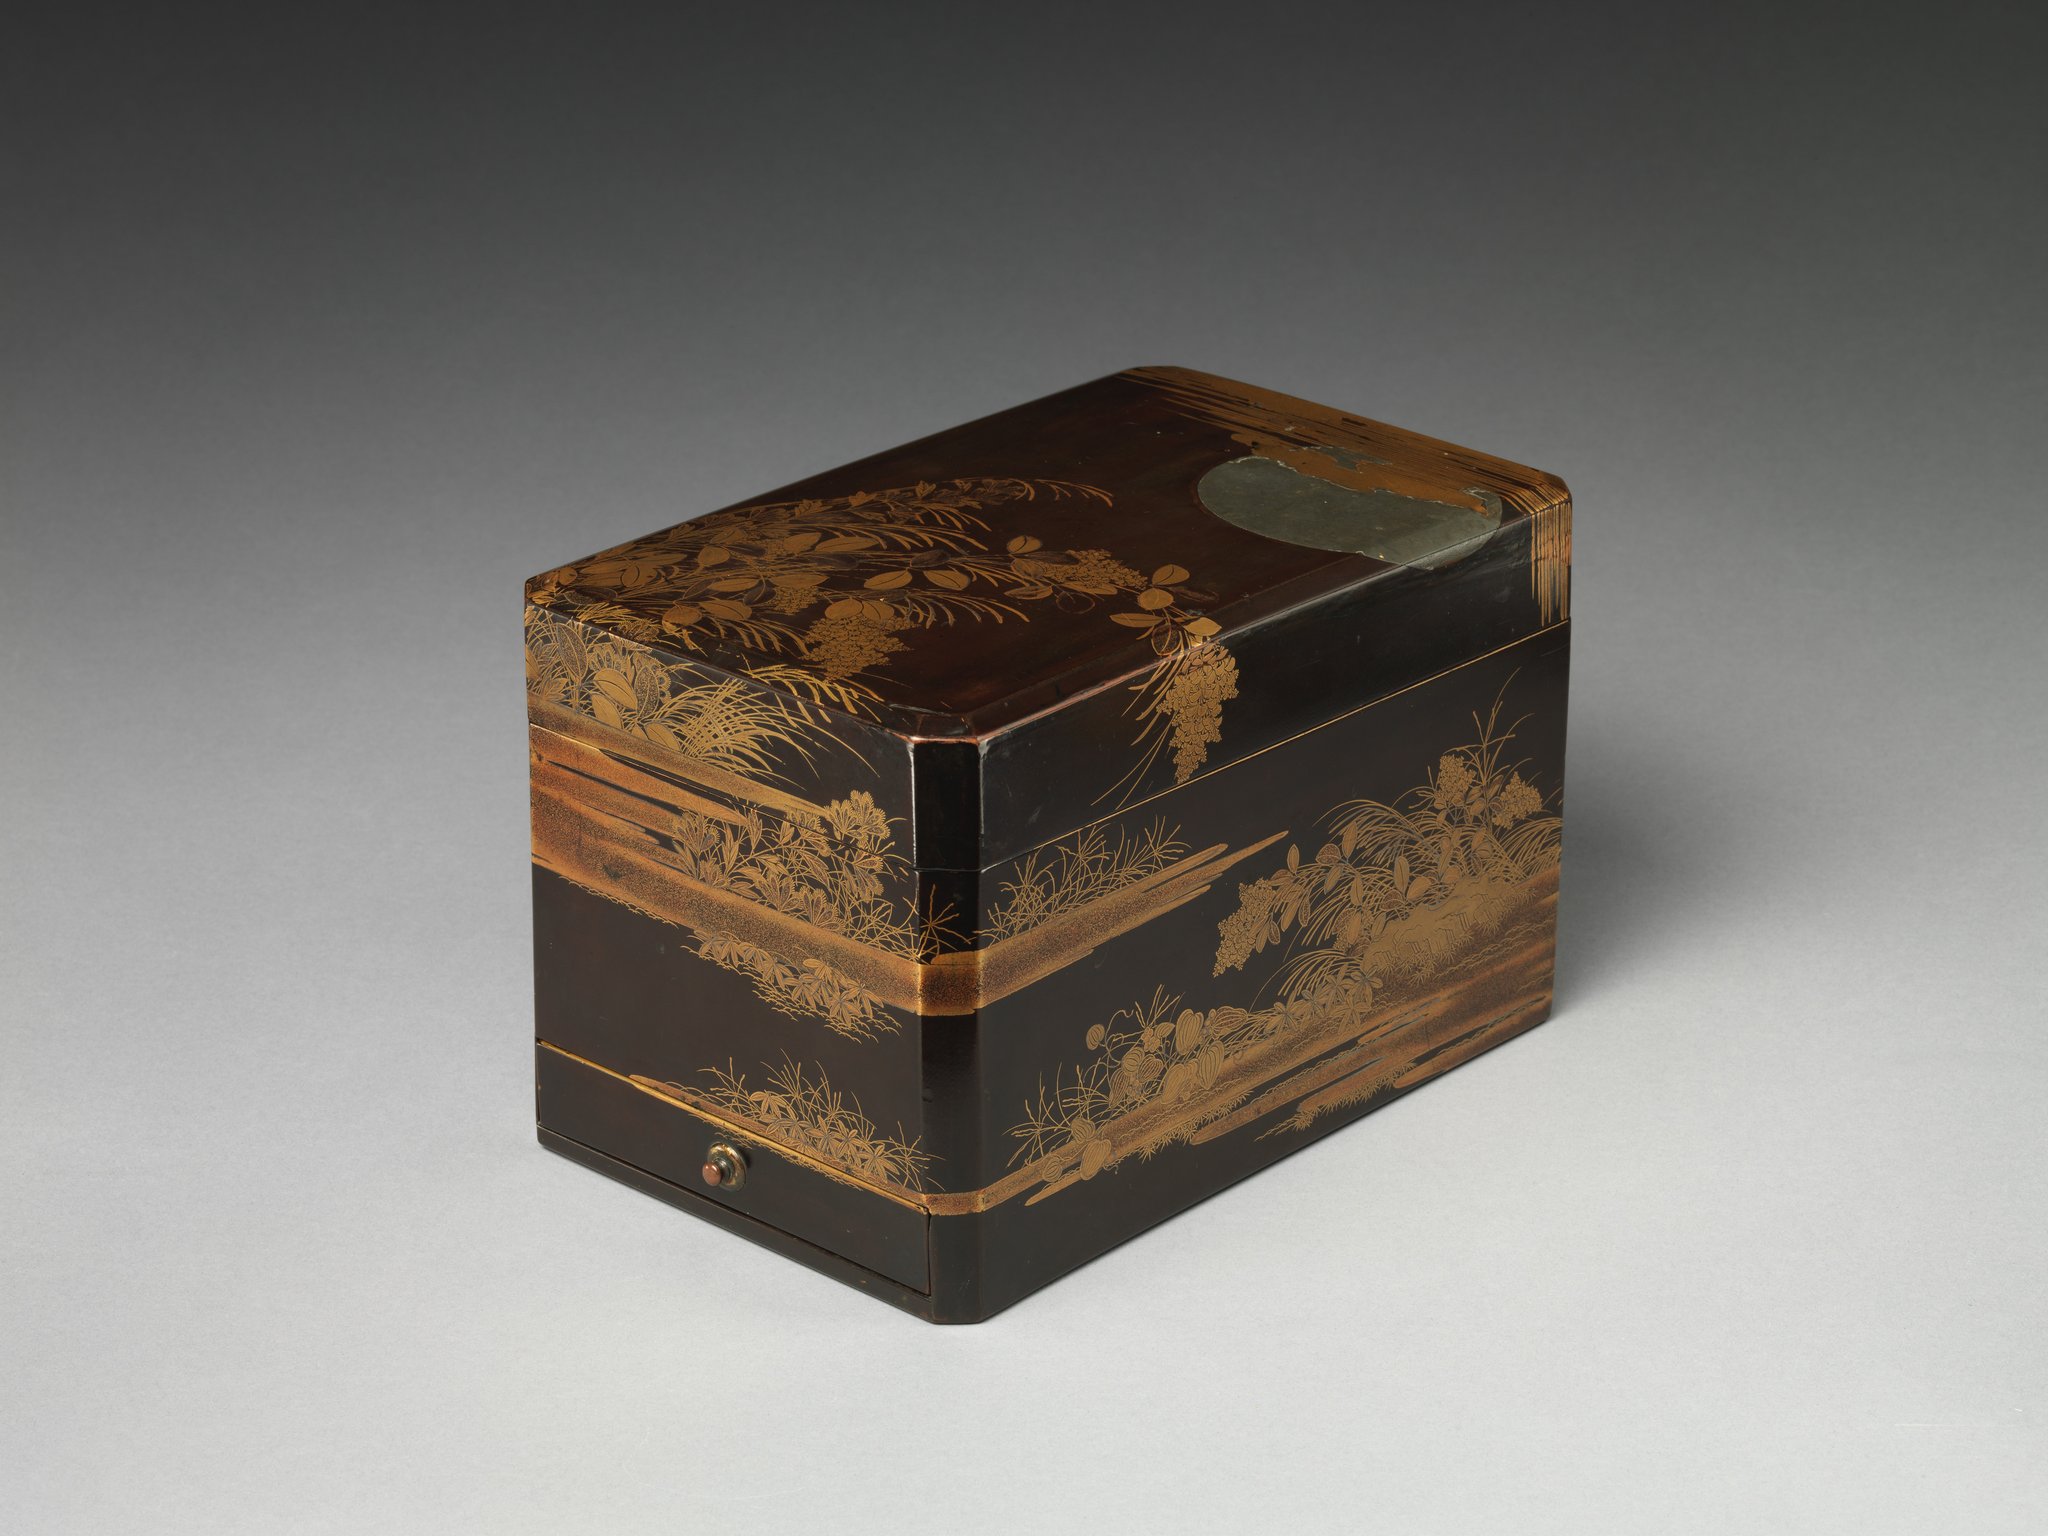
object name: portable stationery and cosmetic box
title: Portable Stationery and Cosmetic Box (Tabi kushi-bako) with Moon and Autumn Grasses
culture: japanese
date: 1701-1800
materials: gold, pewter, silver, wood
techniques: hiramakie, inlay, lacquer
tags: moon,plants